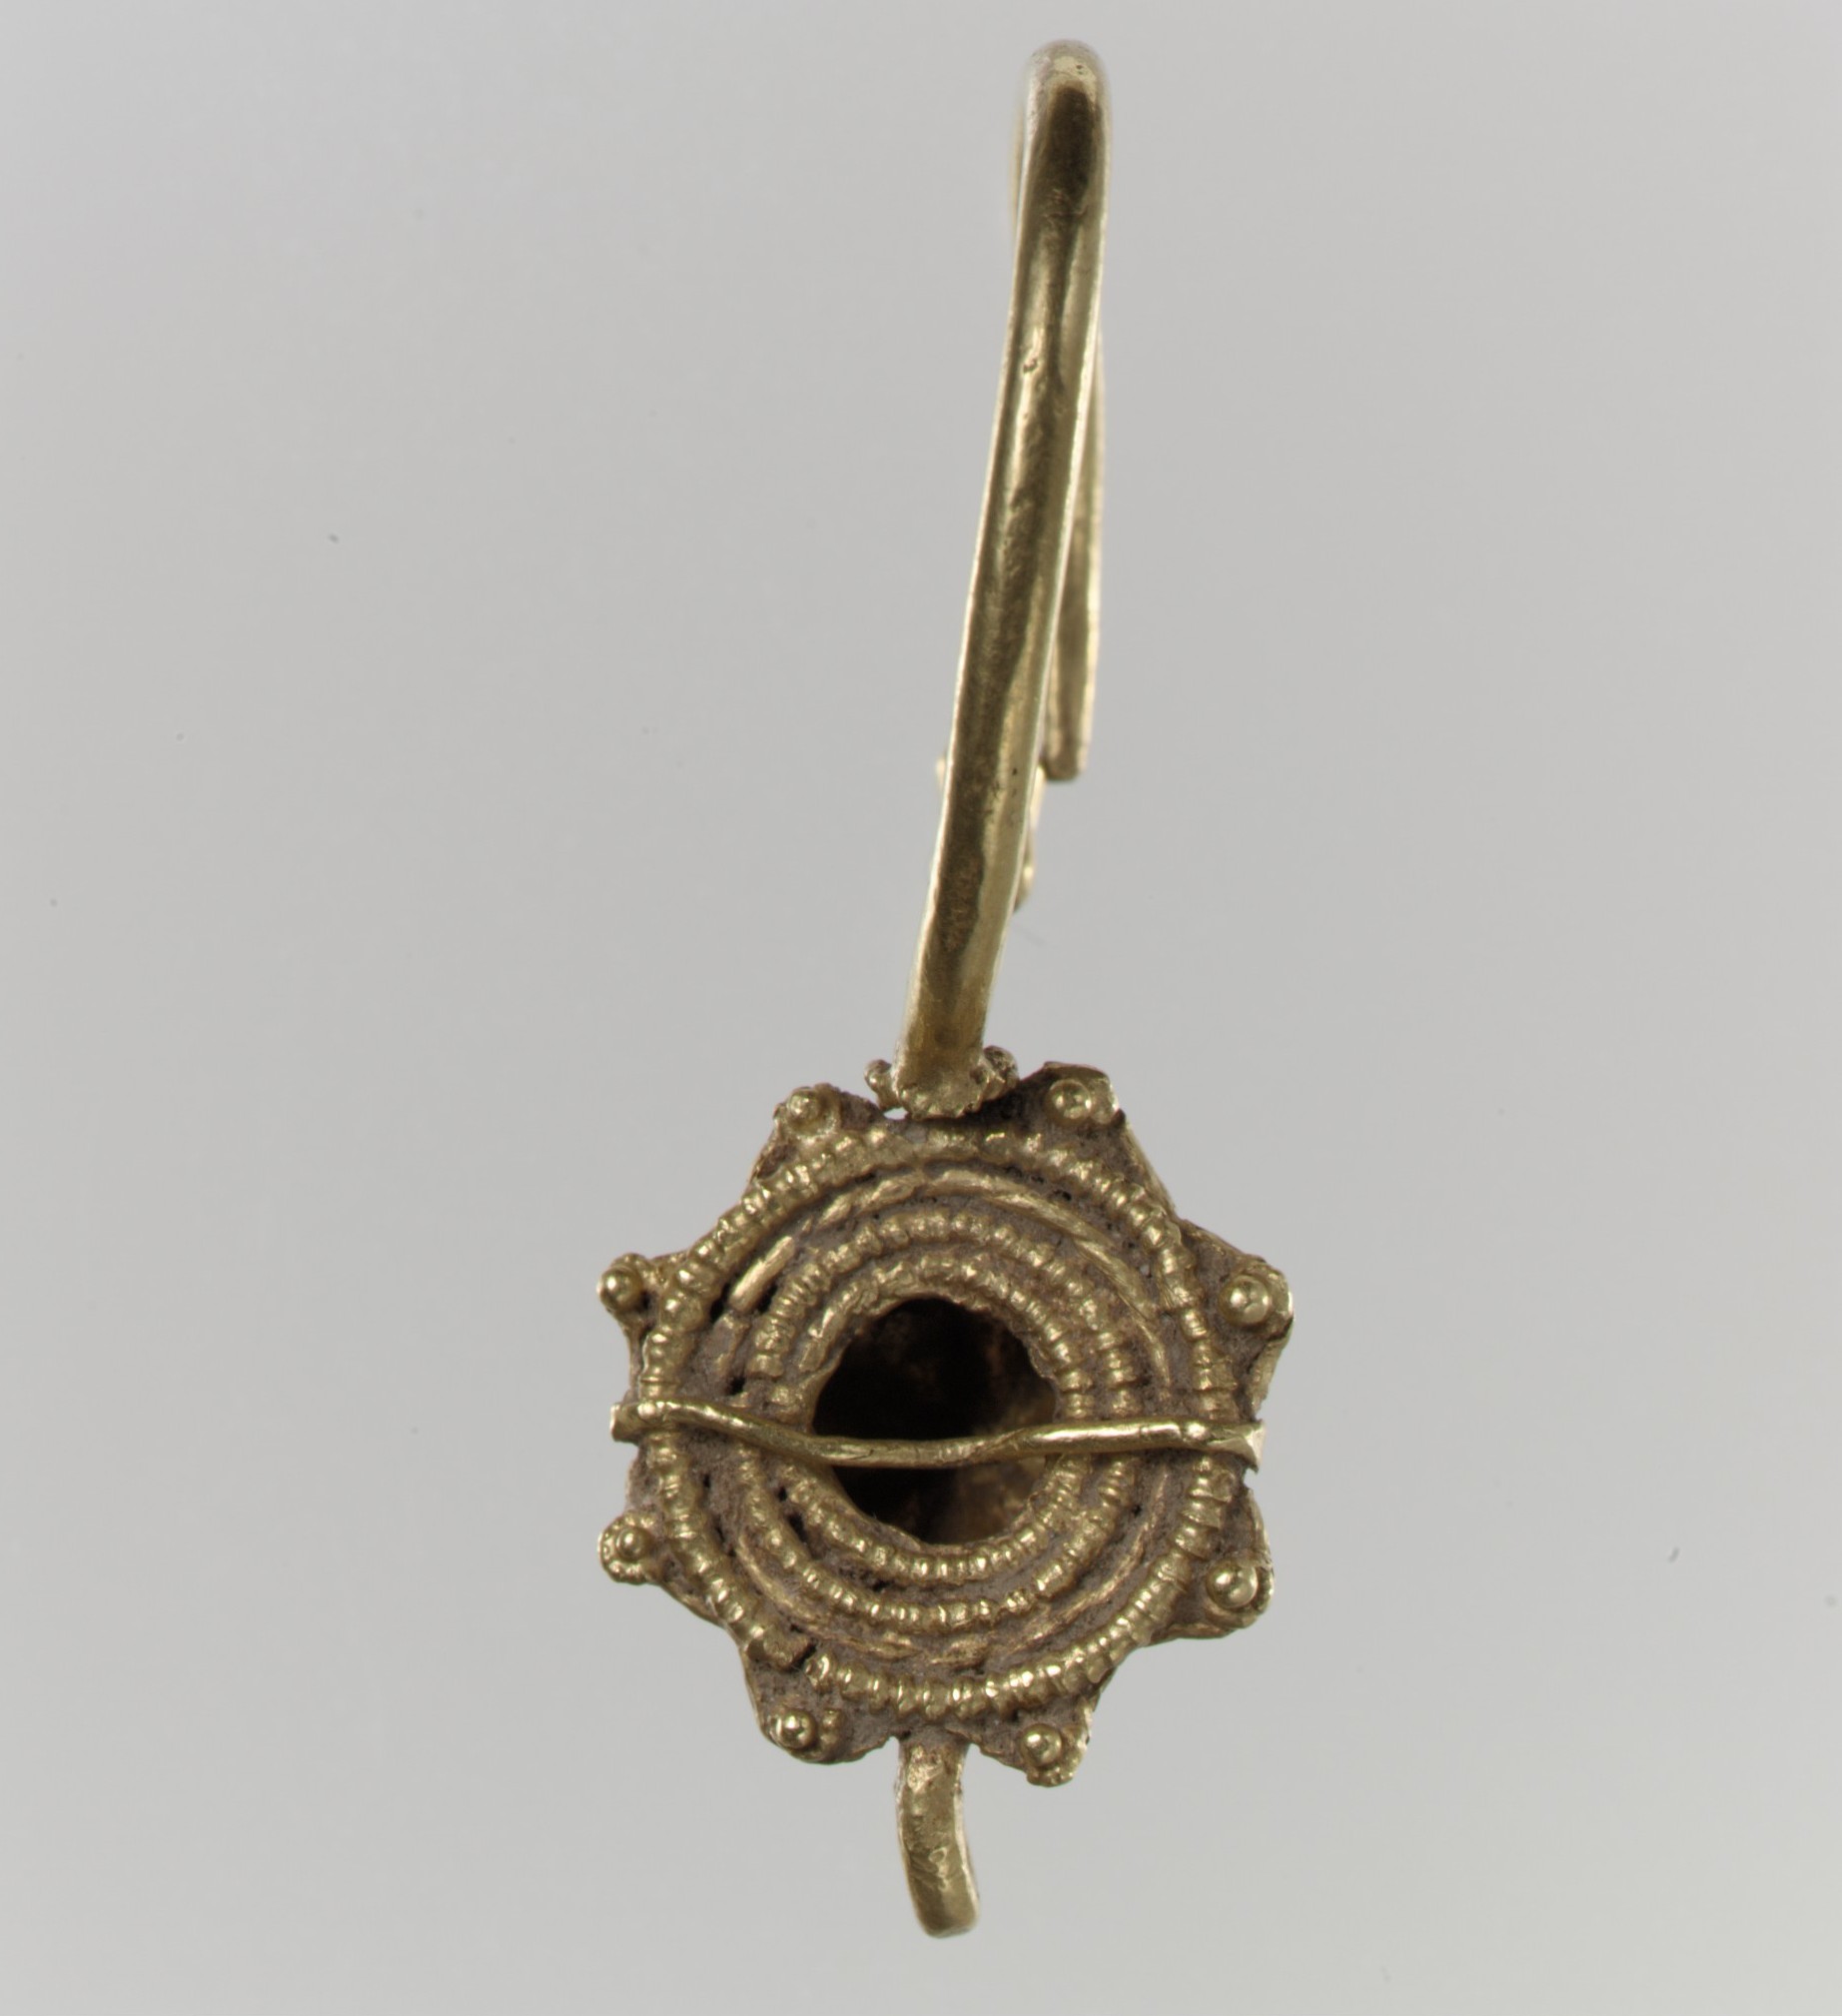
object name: earring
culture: byzantine or langobardic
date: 501-700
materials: gold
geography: italy